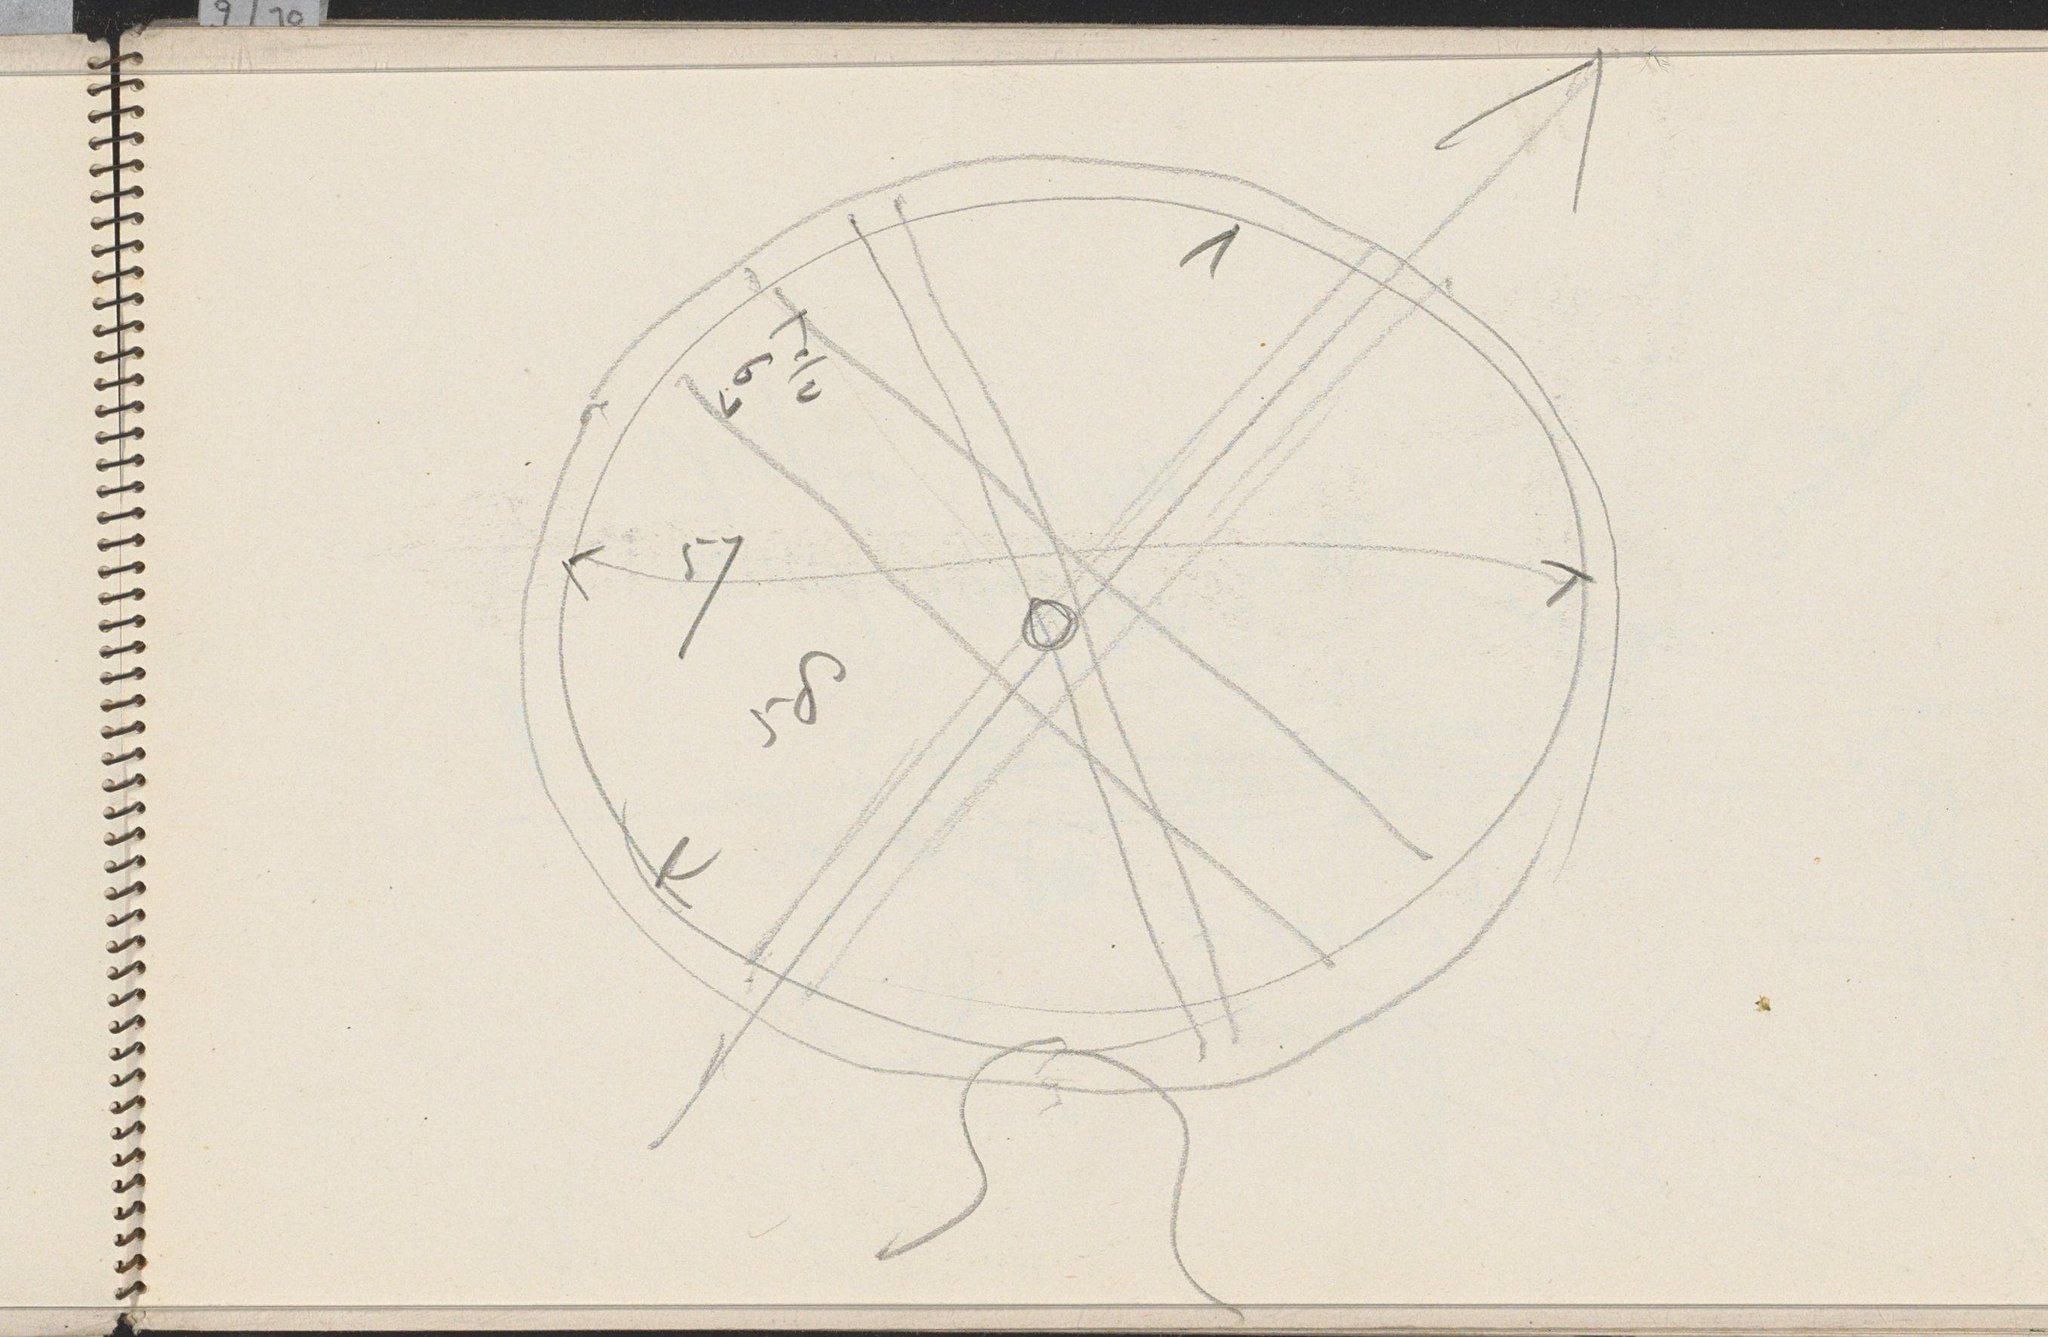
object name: sketchbook leaf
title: In vlakken verdeelde cirkel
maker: carel adolph lion cachet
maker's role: draughtsman, print maker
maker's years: 1864-1945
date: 1930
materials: paper, pencil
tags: circle (~ planimetry, geometry)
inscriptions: annotation: ‘[...]’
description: Blad 7 recto uit een schetsboek met 20 bladen.